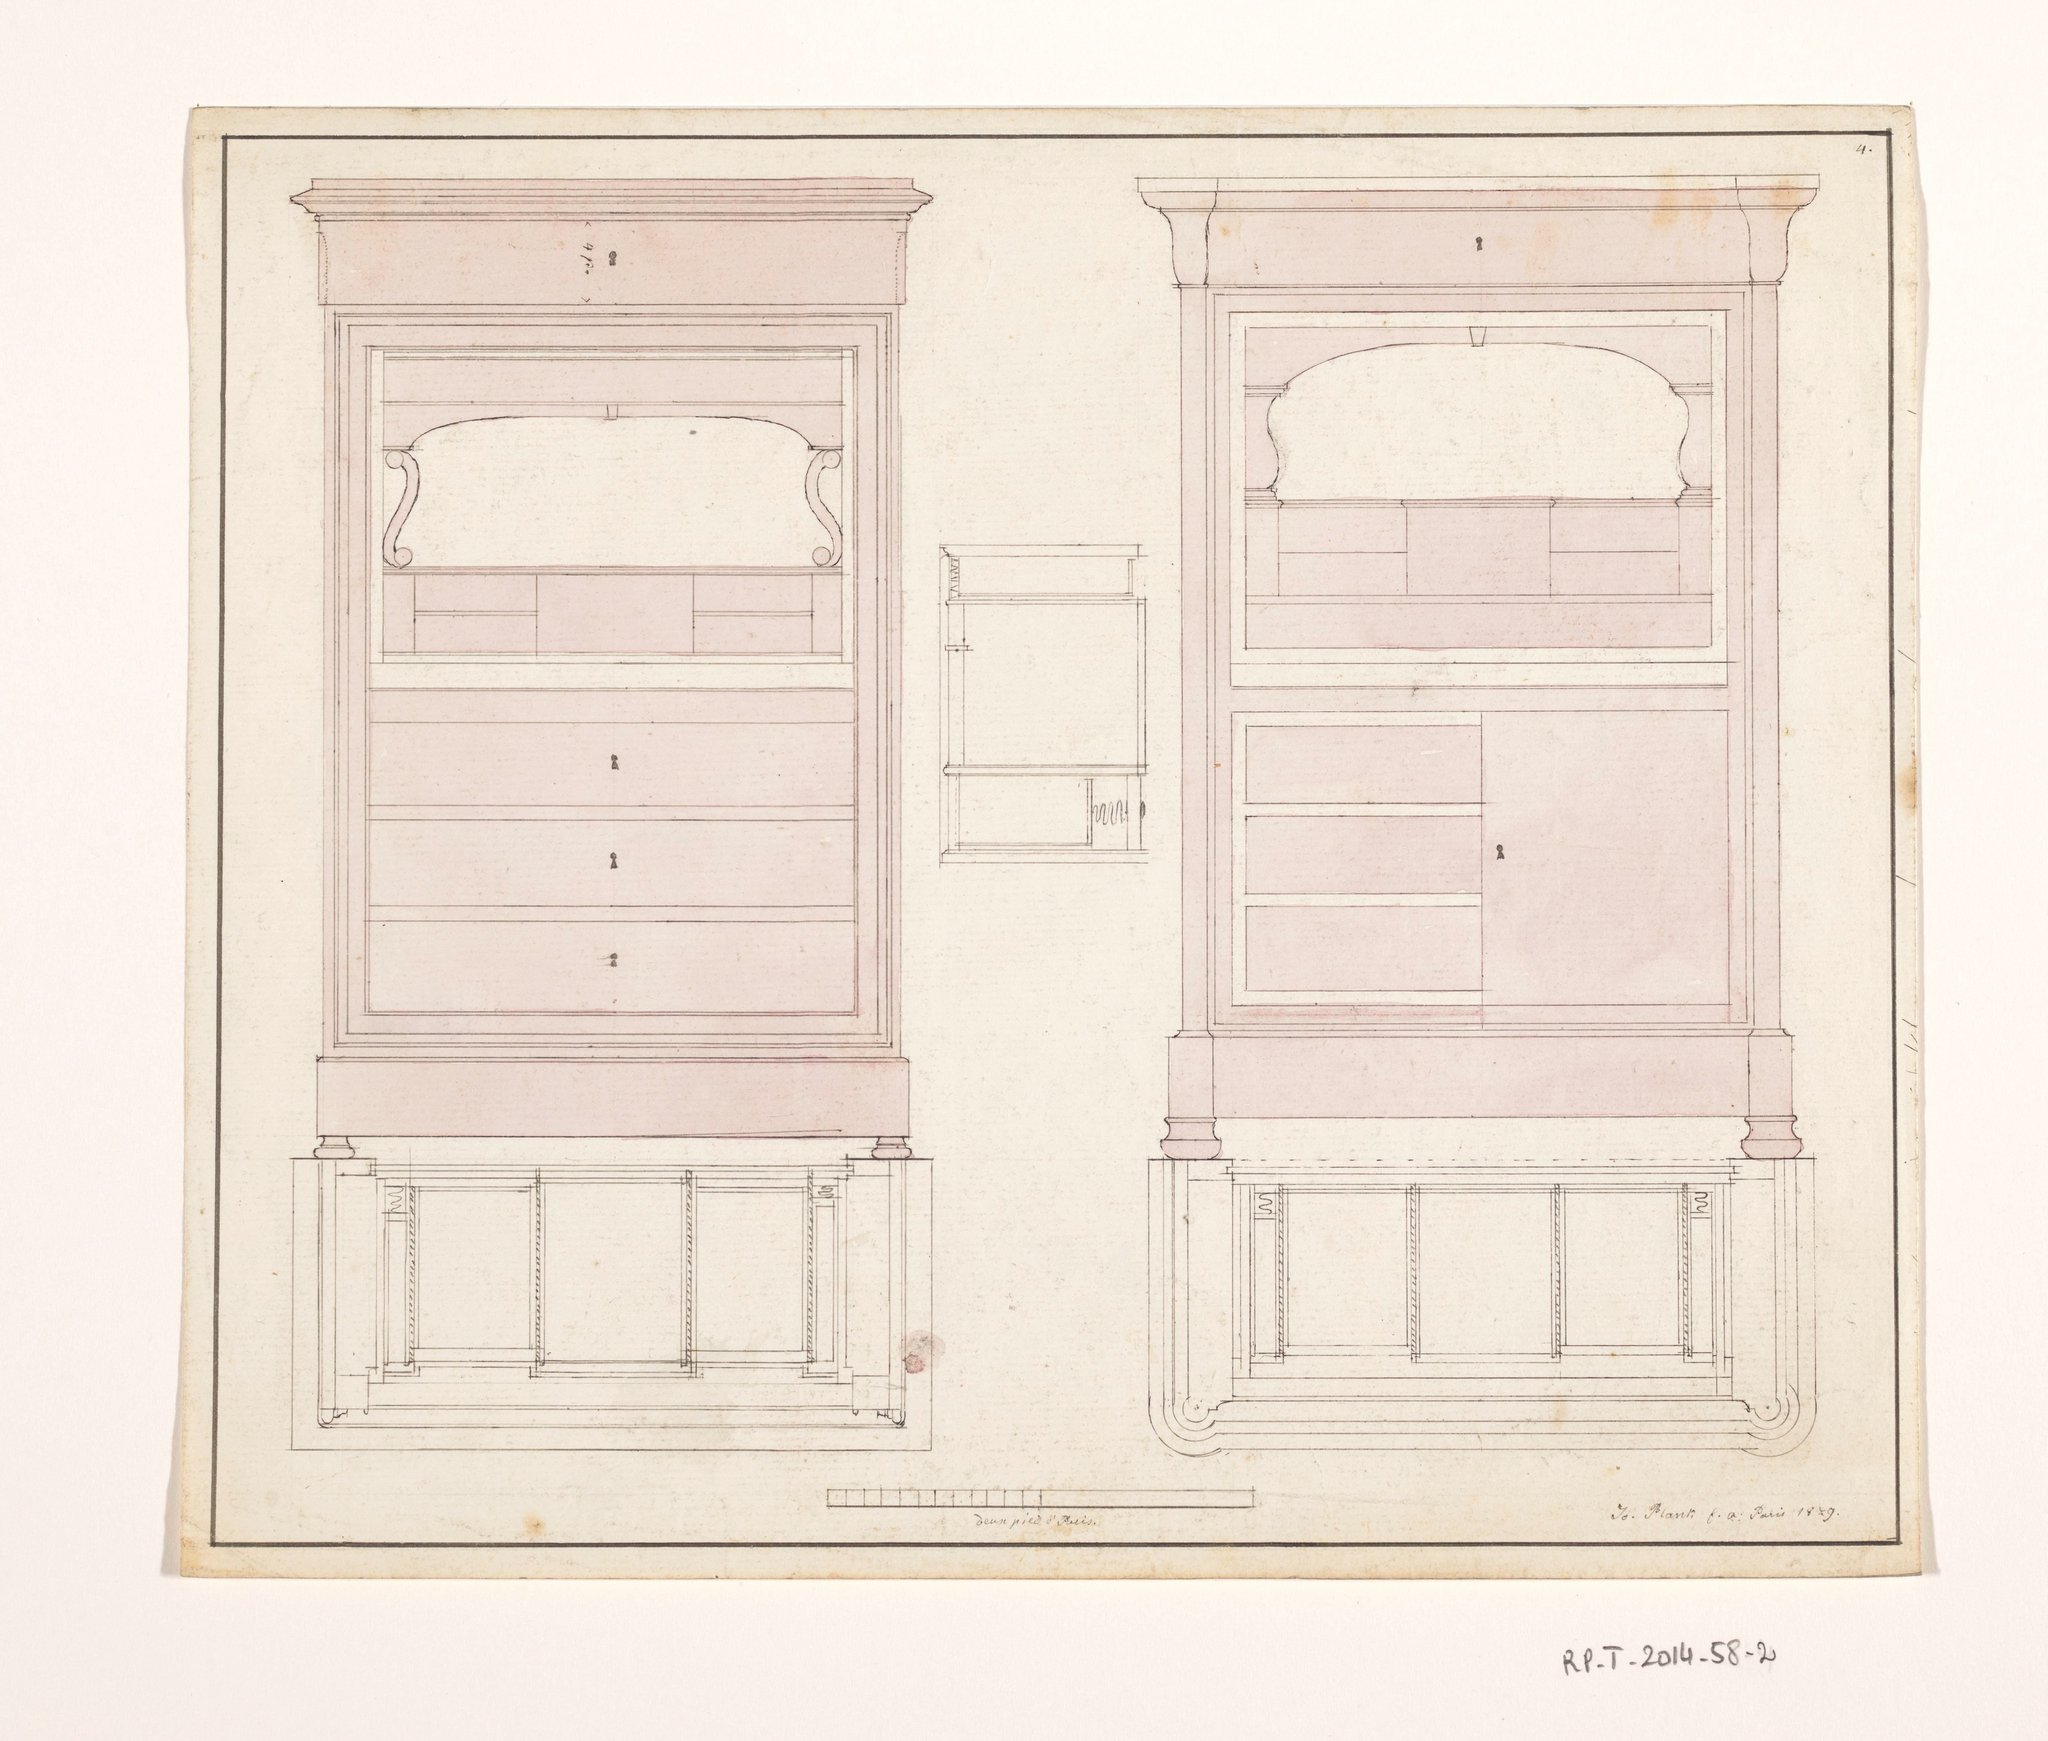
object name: design drawing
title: Ontwerp voor twee secretaires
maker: joachim-pierre blank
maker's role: draughtsman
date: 1829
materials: ink, paper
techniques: brush, pen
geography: paris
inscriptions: signature and date: ‘I. Blank f. a Paris 1829.’, : ‘Maatverdeling met opschrift: deux pied d’Paris.’, watermark, number: ‘4’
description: Ontwerp voor twee secretaires met plattegronden en met het zijaanzicht van het interieur van de bovenkast van de linker secretaire.